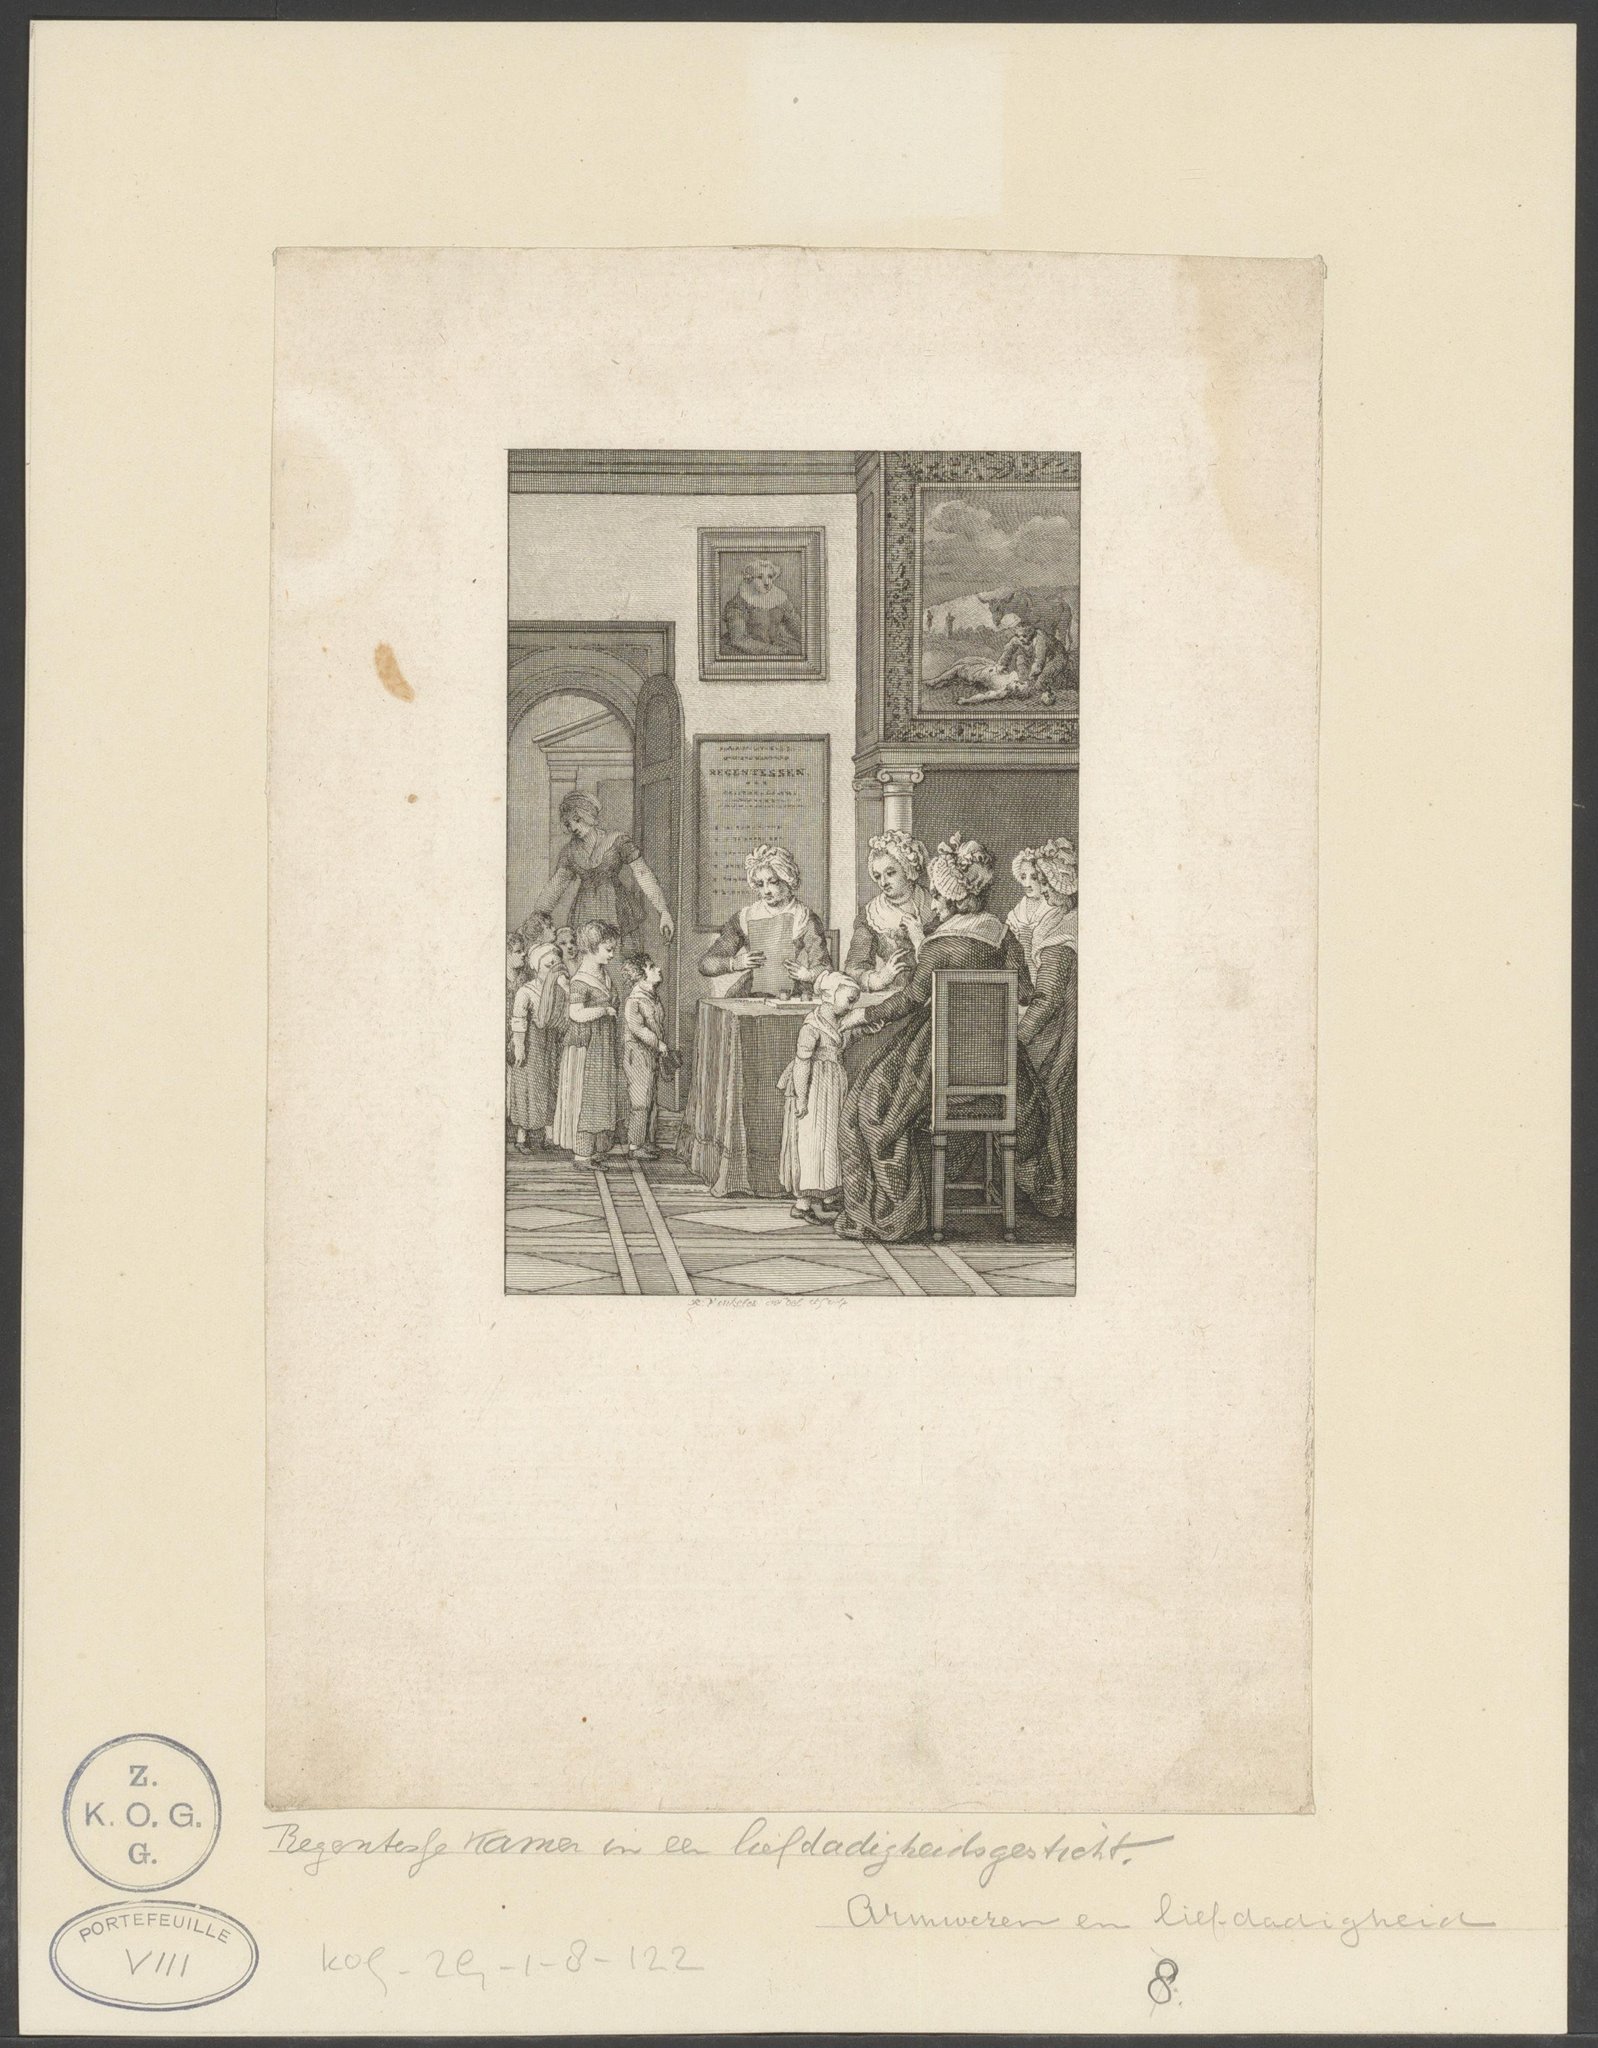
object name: book illustration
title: Vijf regentessen aan een tafel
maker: reinier vinkeles (i)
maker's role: draughtsman, print maker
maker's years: 1741-1816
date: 1809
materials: paper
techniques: engraving, etching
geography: amsterdam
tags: old woman, picture, painting, orphanage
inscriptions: collector's mark: Lugt 1641, collector's mark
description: Kinderen melden zich bij vijf oudere vrouwen, de regentessen van een weeshuis, die aan een tafel zitten. In het vertrek hangen twee schilderijen: het portret van een regentes en een voorstelling van de Barmhartige Samaritaan. De prent is een illustratie voor een boek over de vier 'tijdperken' van de vrouw, hier van het tijdperk 'de bejaarde vrouw'. Staat vóór de opschriften. Onderwerpsrubrieken binnen de Atlas Zeden en Gewoonten: Armwezen en Liefdadigheid.